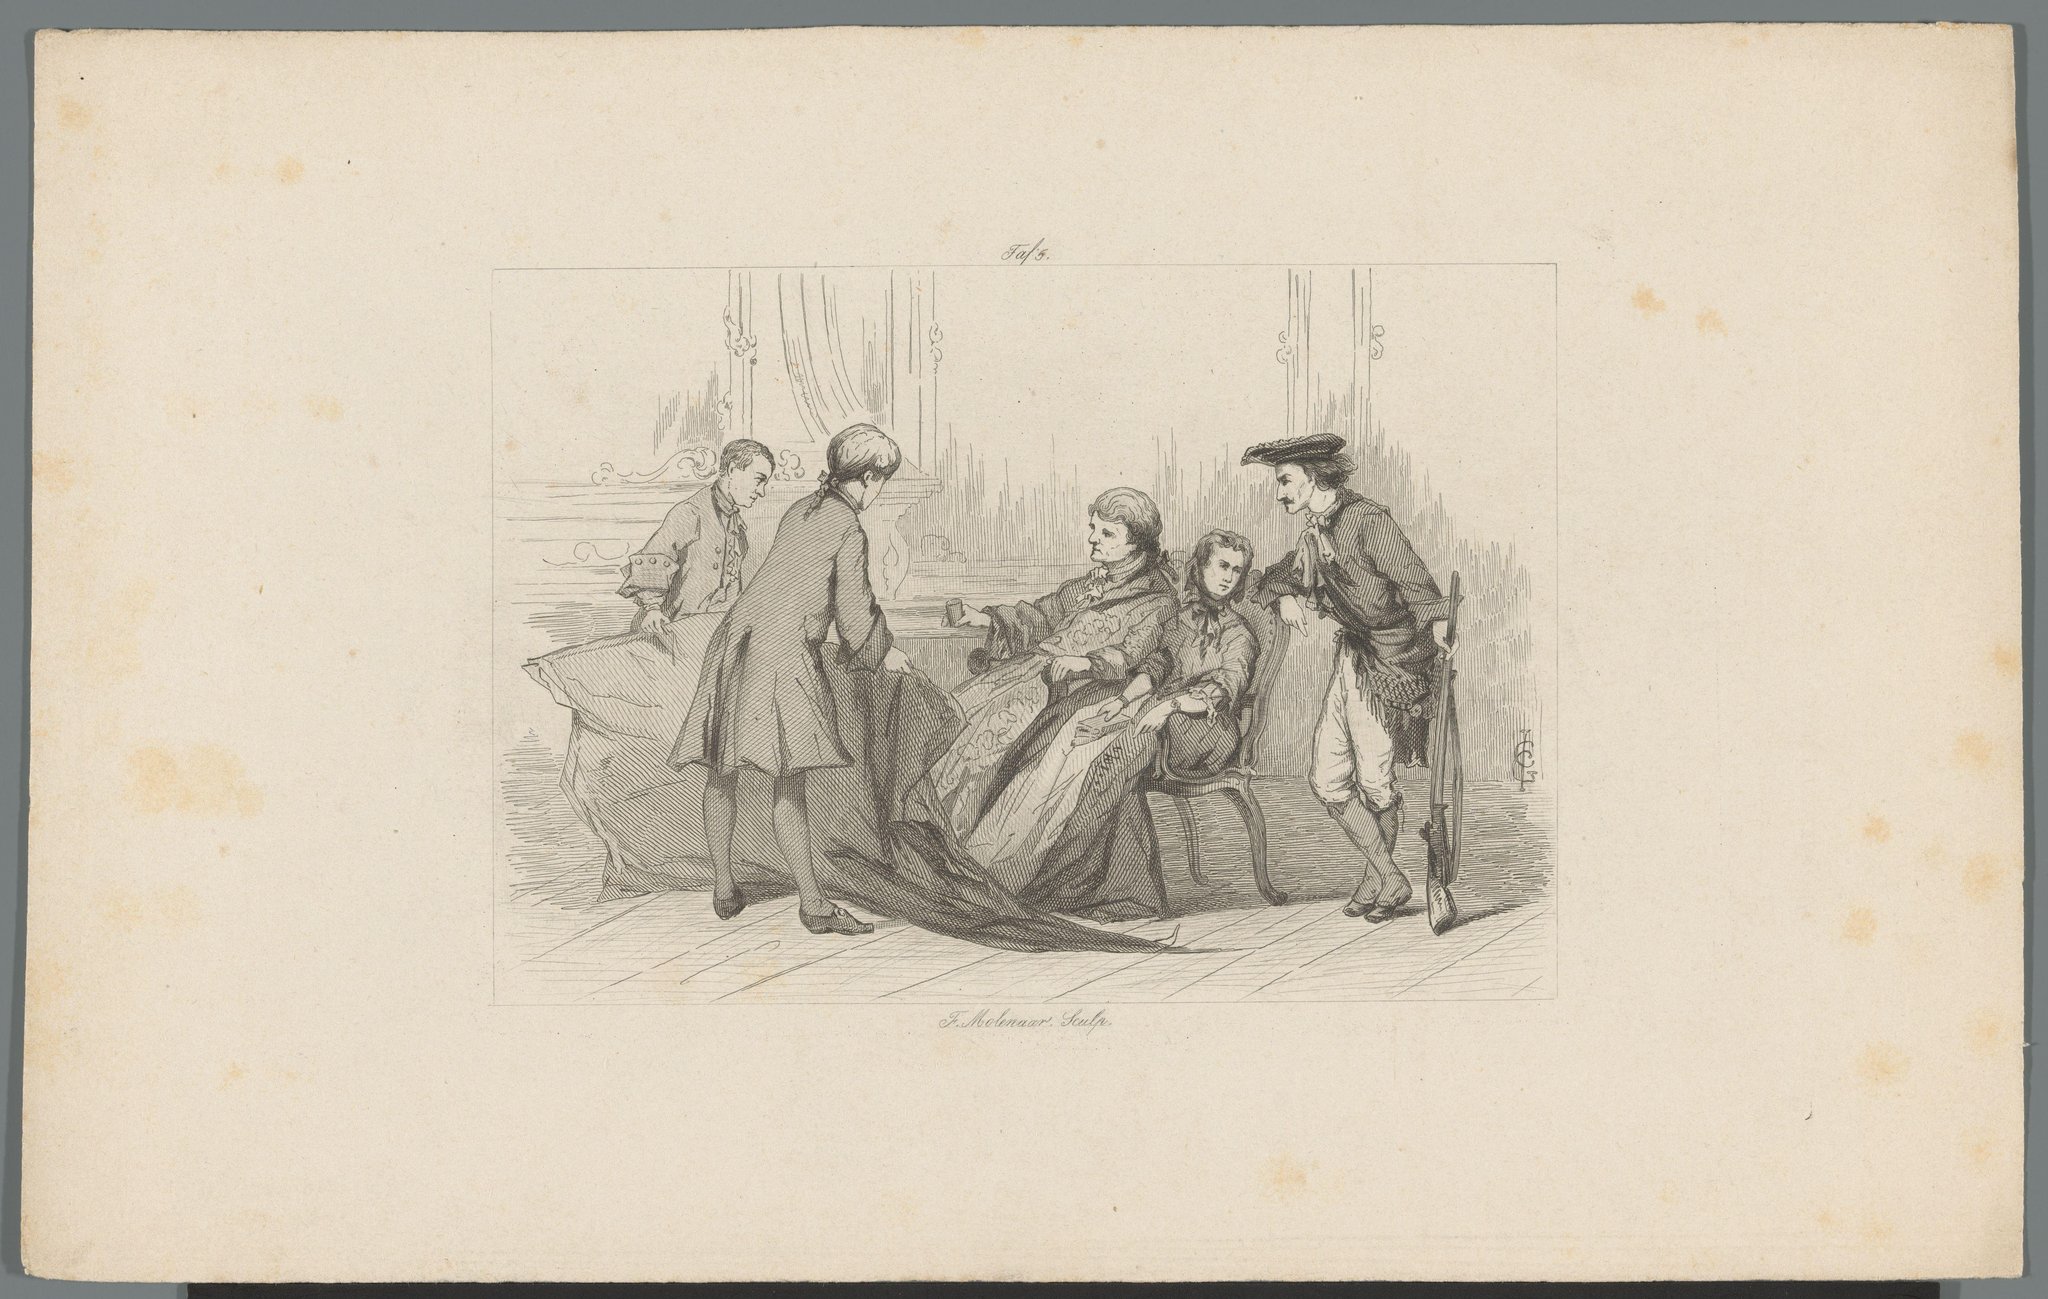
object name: print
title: Man bekijkt geschilderd behangsel, 18e eeuw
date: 1864-1865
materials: paper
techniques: etching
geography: amsterdam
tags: painter in non-work situation, wall-covering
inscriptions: collector's mark: Lugt 2228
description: Scène uit de achttiende eeuw: een man gezeten in een stoel bekijkt een geschilderd behangsel voor hem opgehouden door de schilder en zijn assistent. Onderdeel van een serie van zes voorstellingen van momenten uit de Nederlandse geschiedenis voorgesteld in tableaux vivants door leden van Arti et Amicitiae te Amsterdam op 2 december 1864.